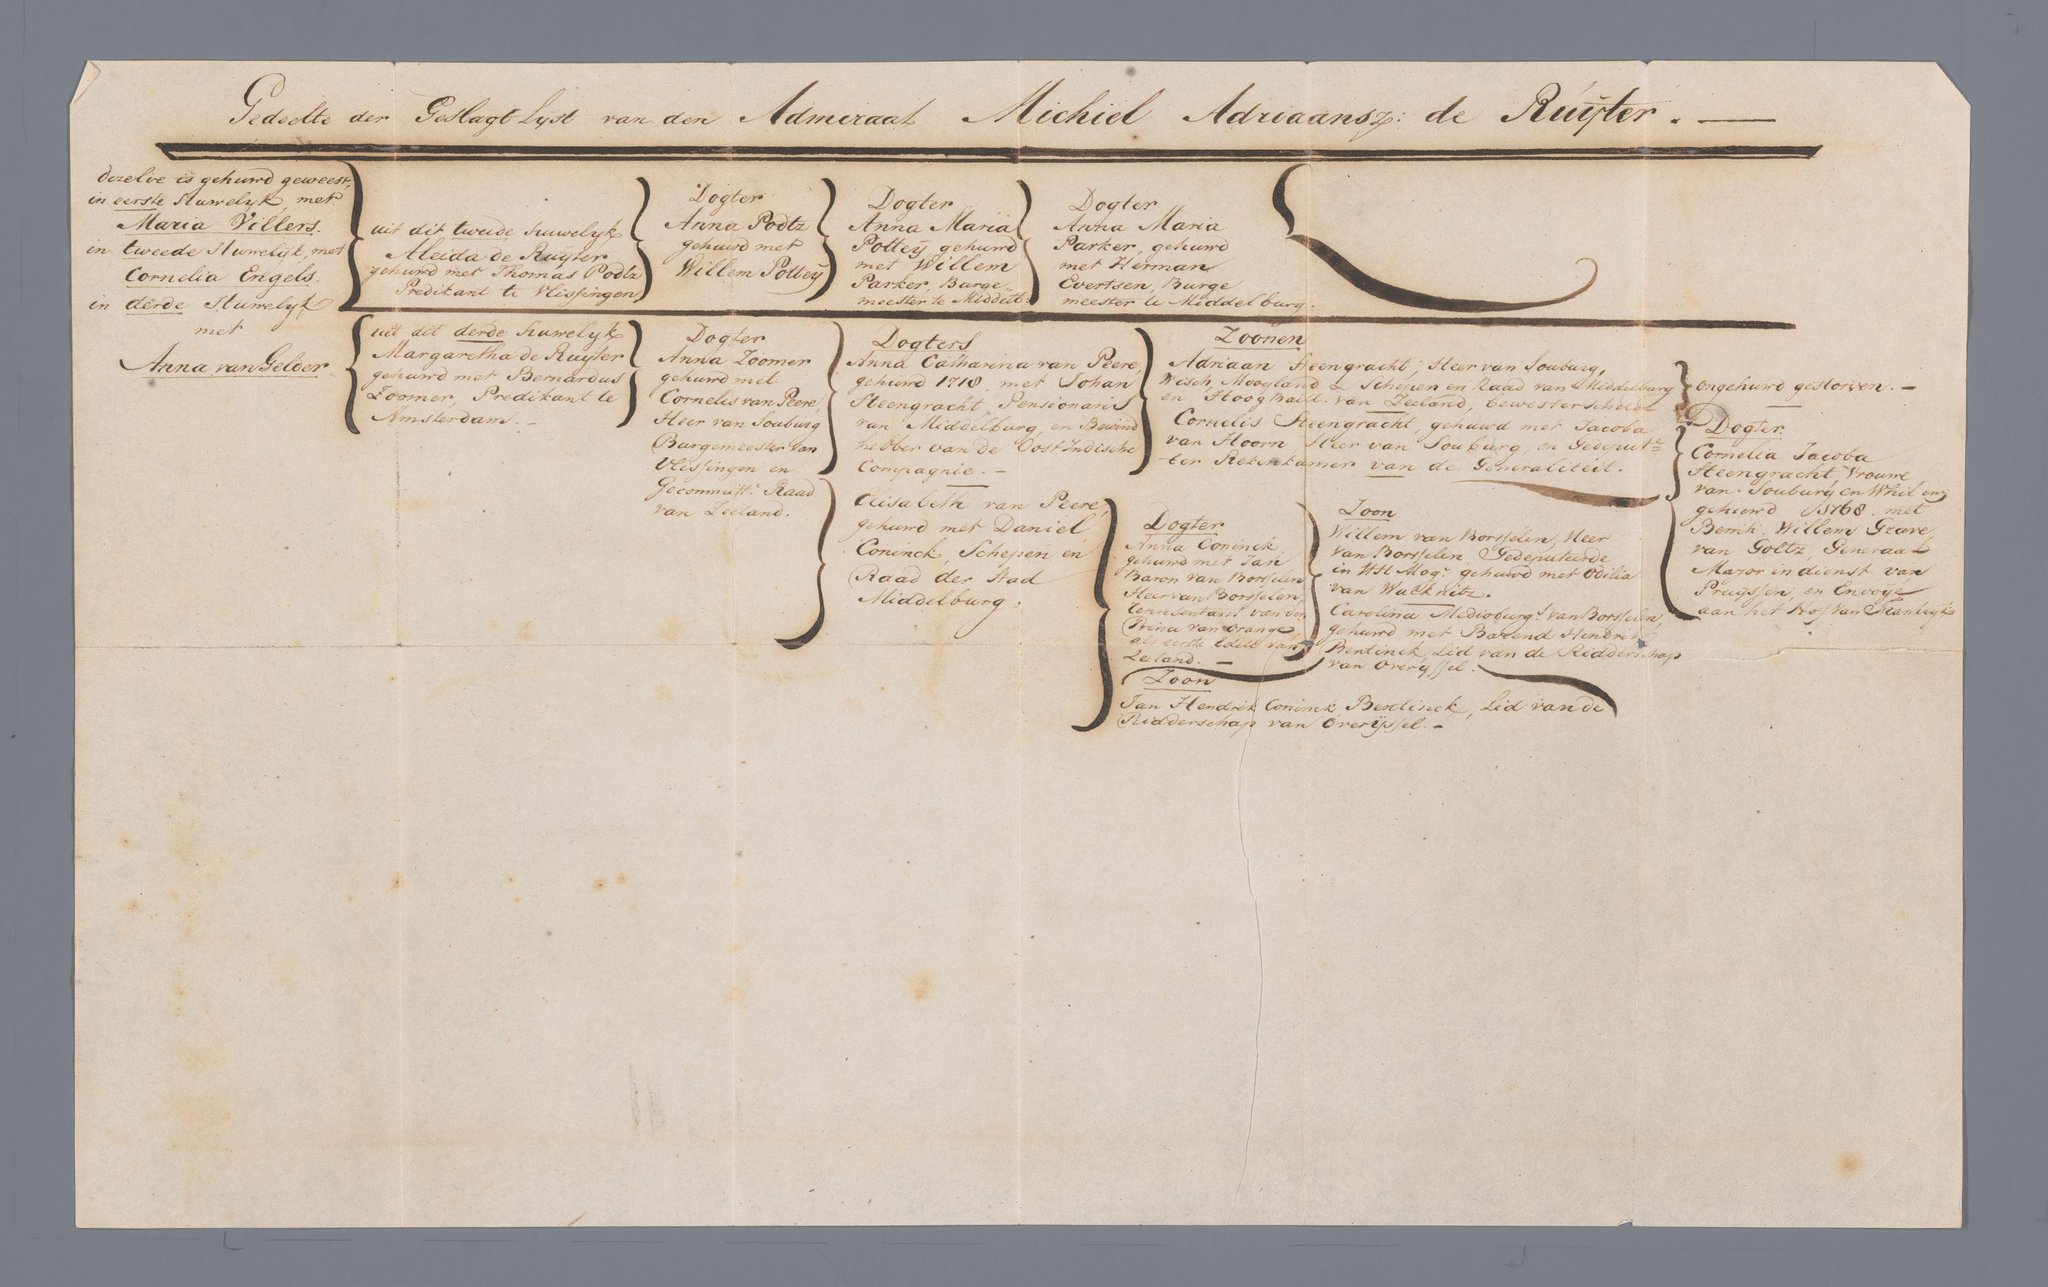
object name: manuscript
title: Gedeelte der Geslagtlijst van den Admiraal Michiel Adriaansz. de Ruyter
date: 1768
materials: ink, paper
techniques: writing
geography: netherlands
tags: flushing, michiel adriaenszoon de ruyter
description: Blad eenzijdig beschreven papier in bruin verkleurde inkt. geslachtslijst links beginnend met de drie vrouwen van Michiel Adriaenszoon de Ruyter, eindigend rechts met het huwelijk (1768) tussen Cornelis Jacoba Steengracht en Bernhard Willem graaf van Goltz. Opschrift: Gedeelte der Geslagtlijst van den Admiraal Michiel Adraansz: de Ruyter.